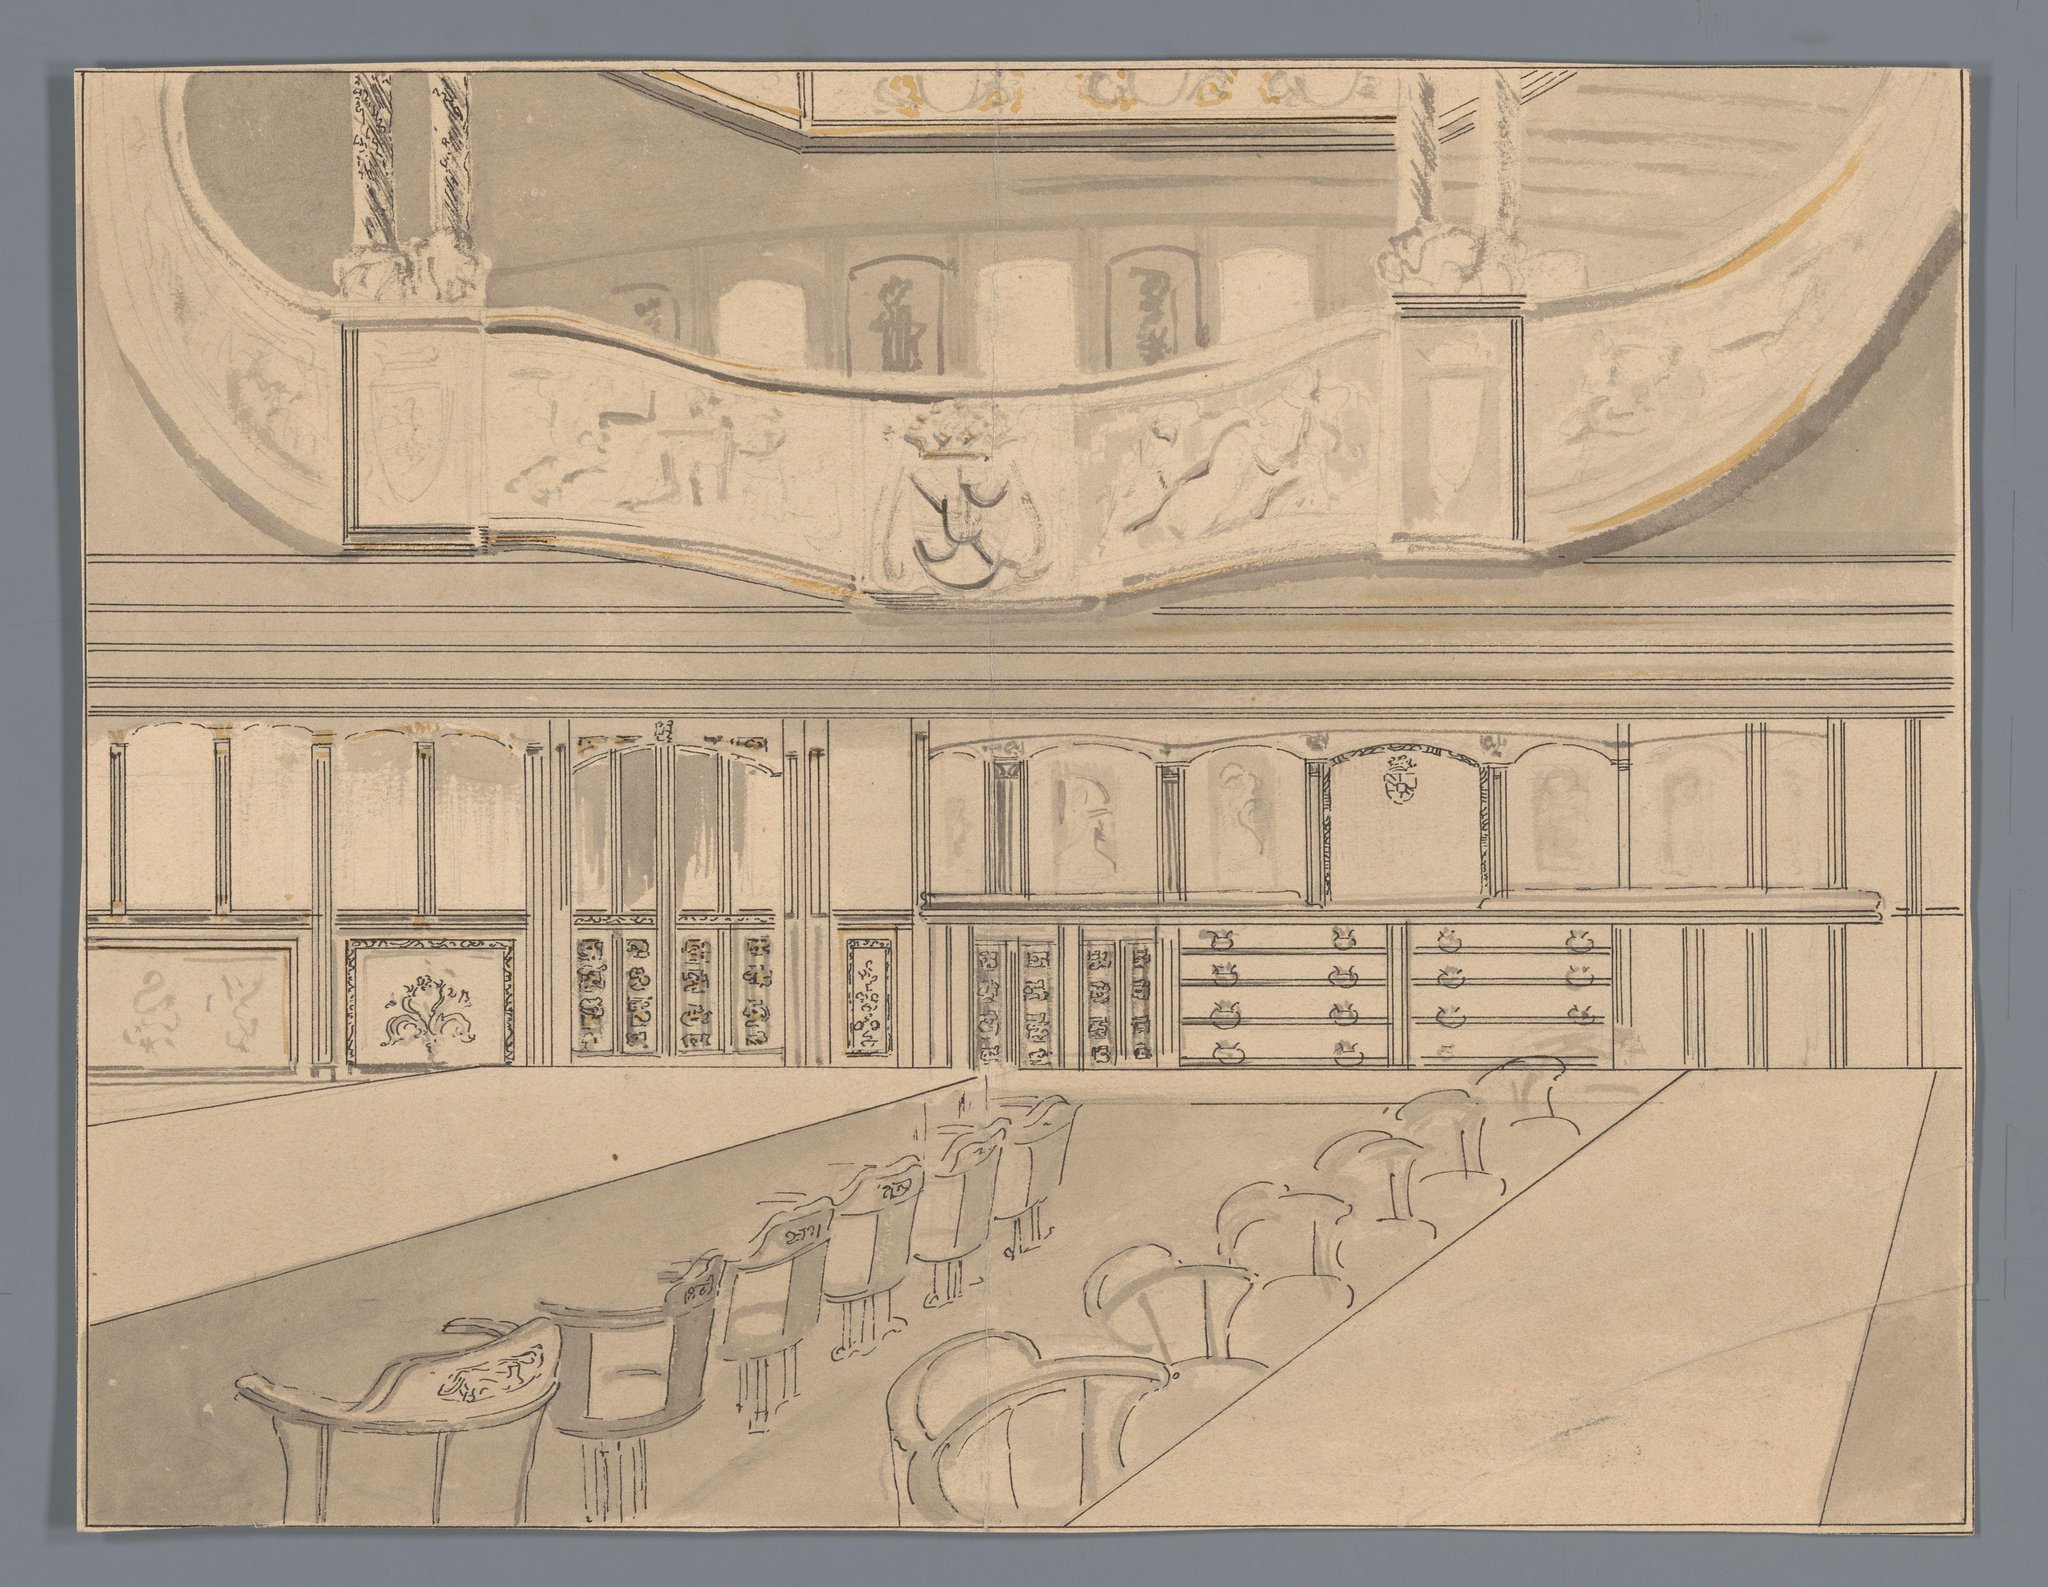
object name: drawing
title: Ontwerp voor de eetzaal van de Mailboot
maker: carel adolph lion cachet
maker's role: draughtsman, print maker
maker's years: 1864-1945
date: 1874-1945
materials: ink, paper, pencil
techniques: brush, pen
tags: names of artefacts and man-made objects (buildings excluded), interior of the house, parts of ship's interior